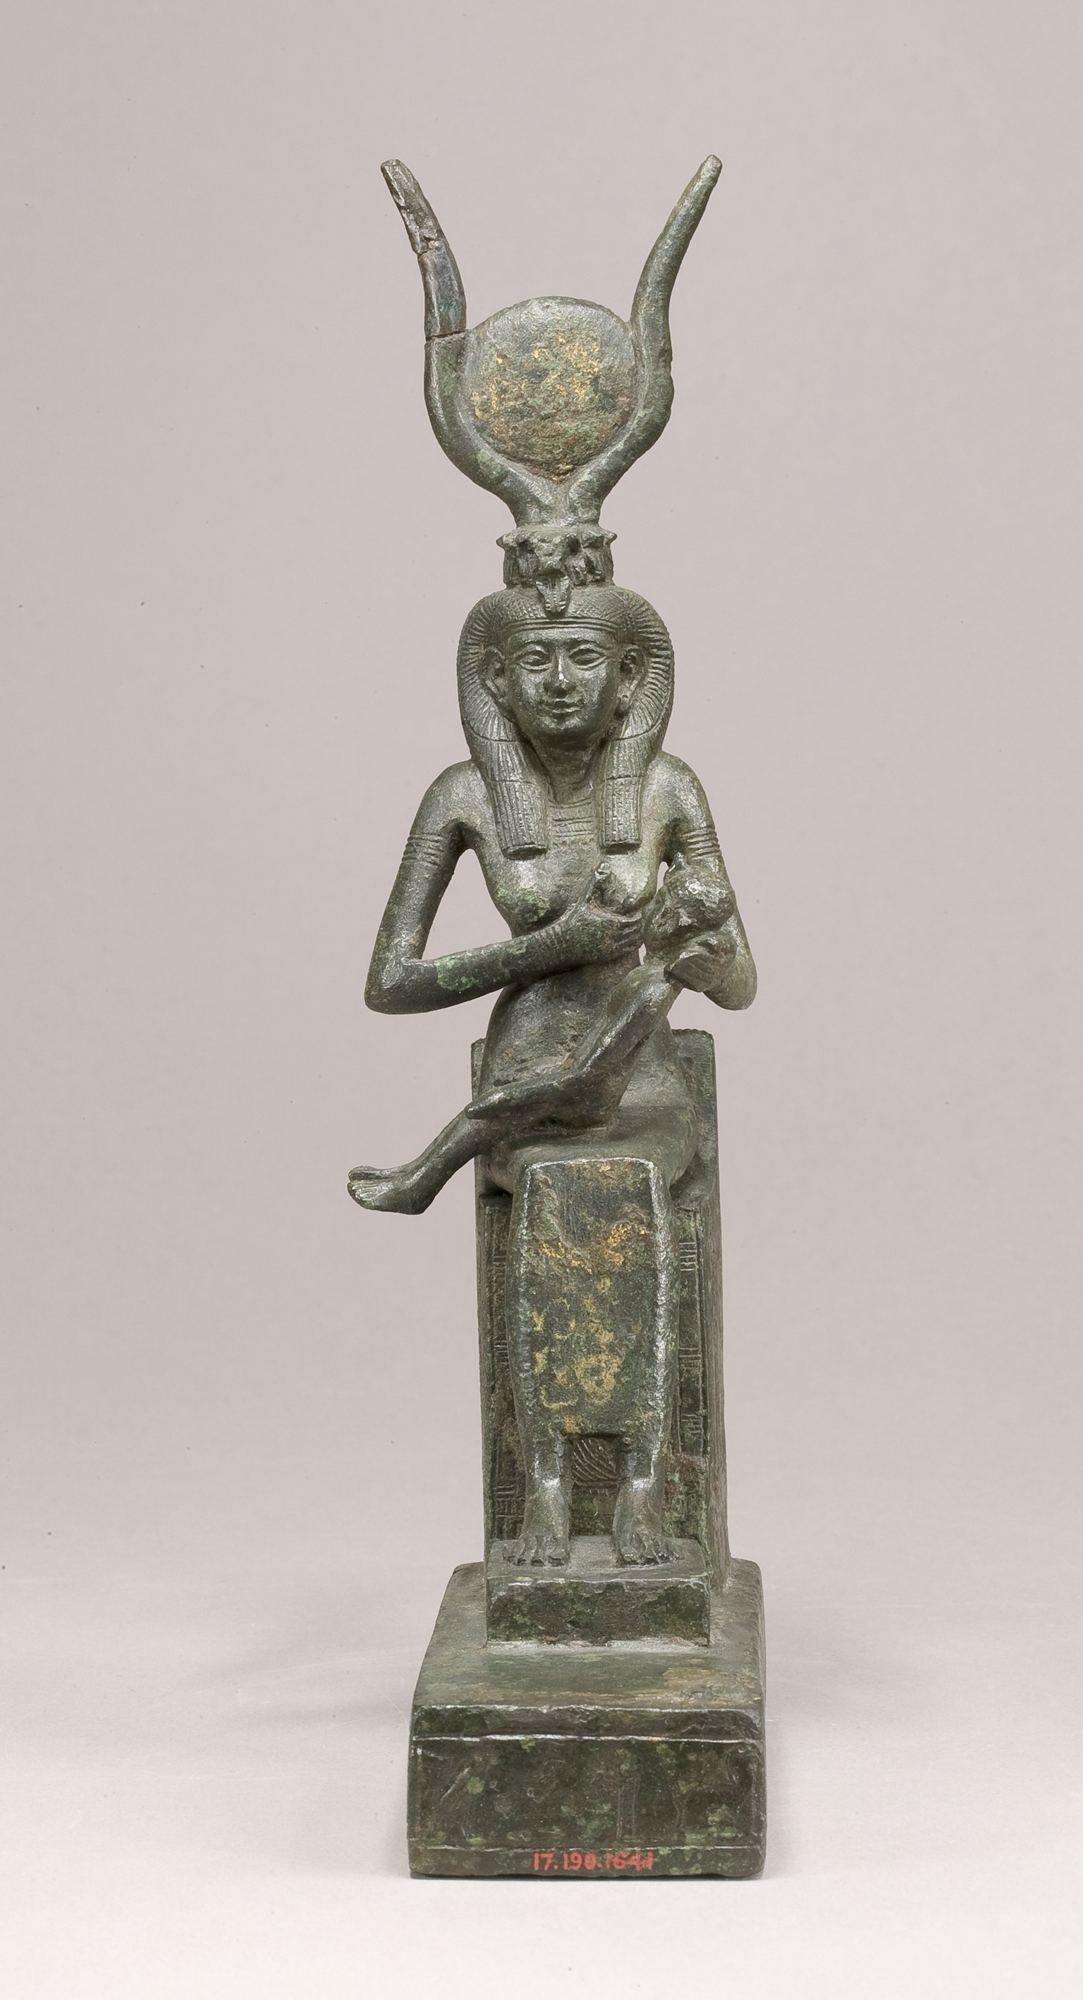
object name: statuette, isi, horus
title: Isis nursing Horus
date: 1070-343 BCE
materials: bronze, copper alloy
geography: egypt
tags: horus,isis